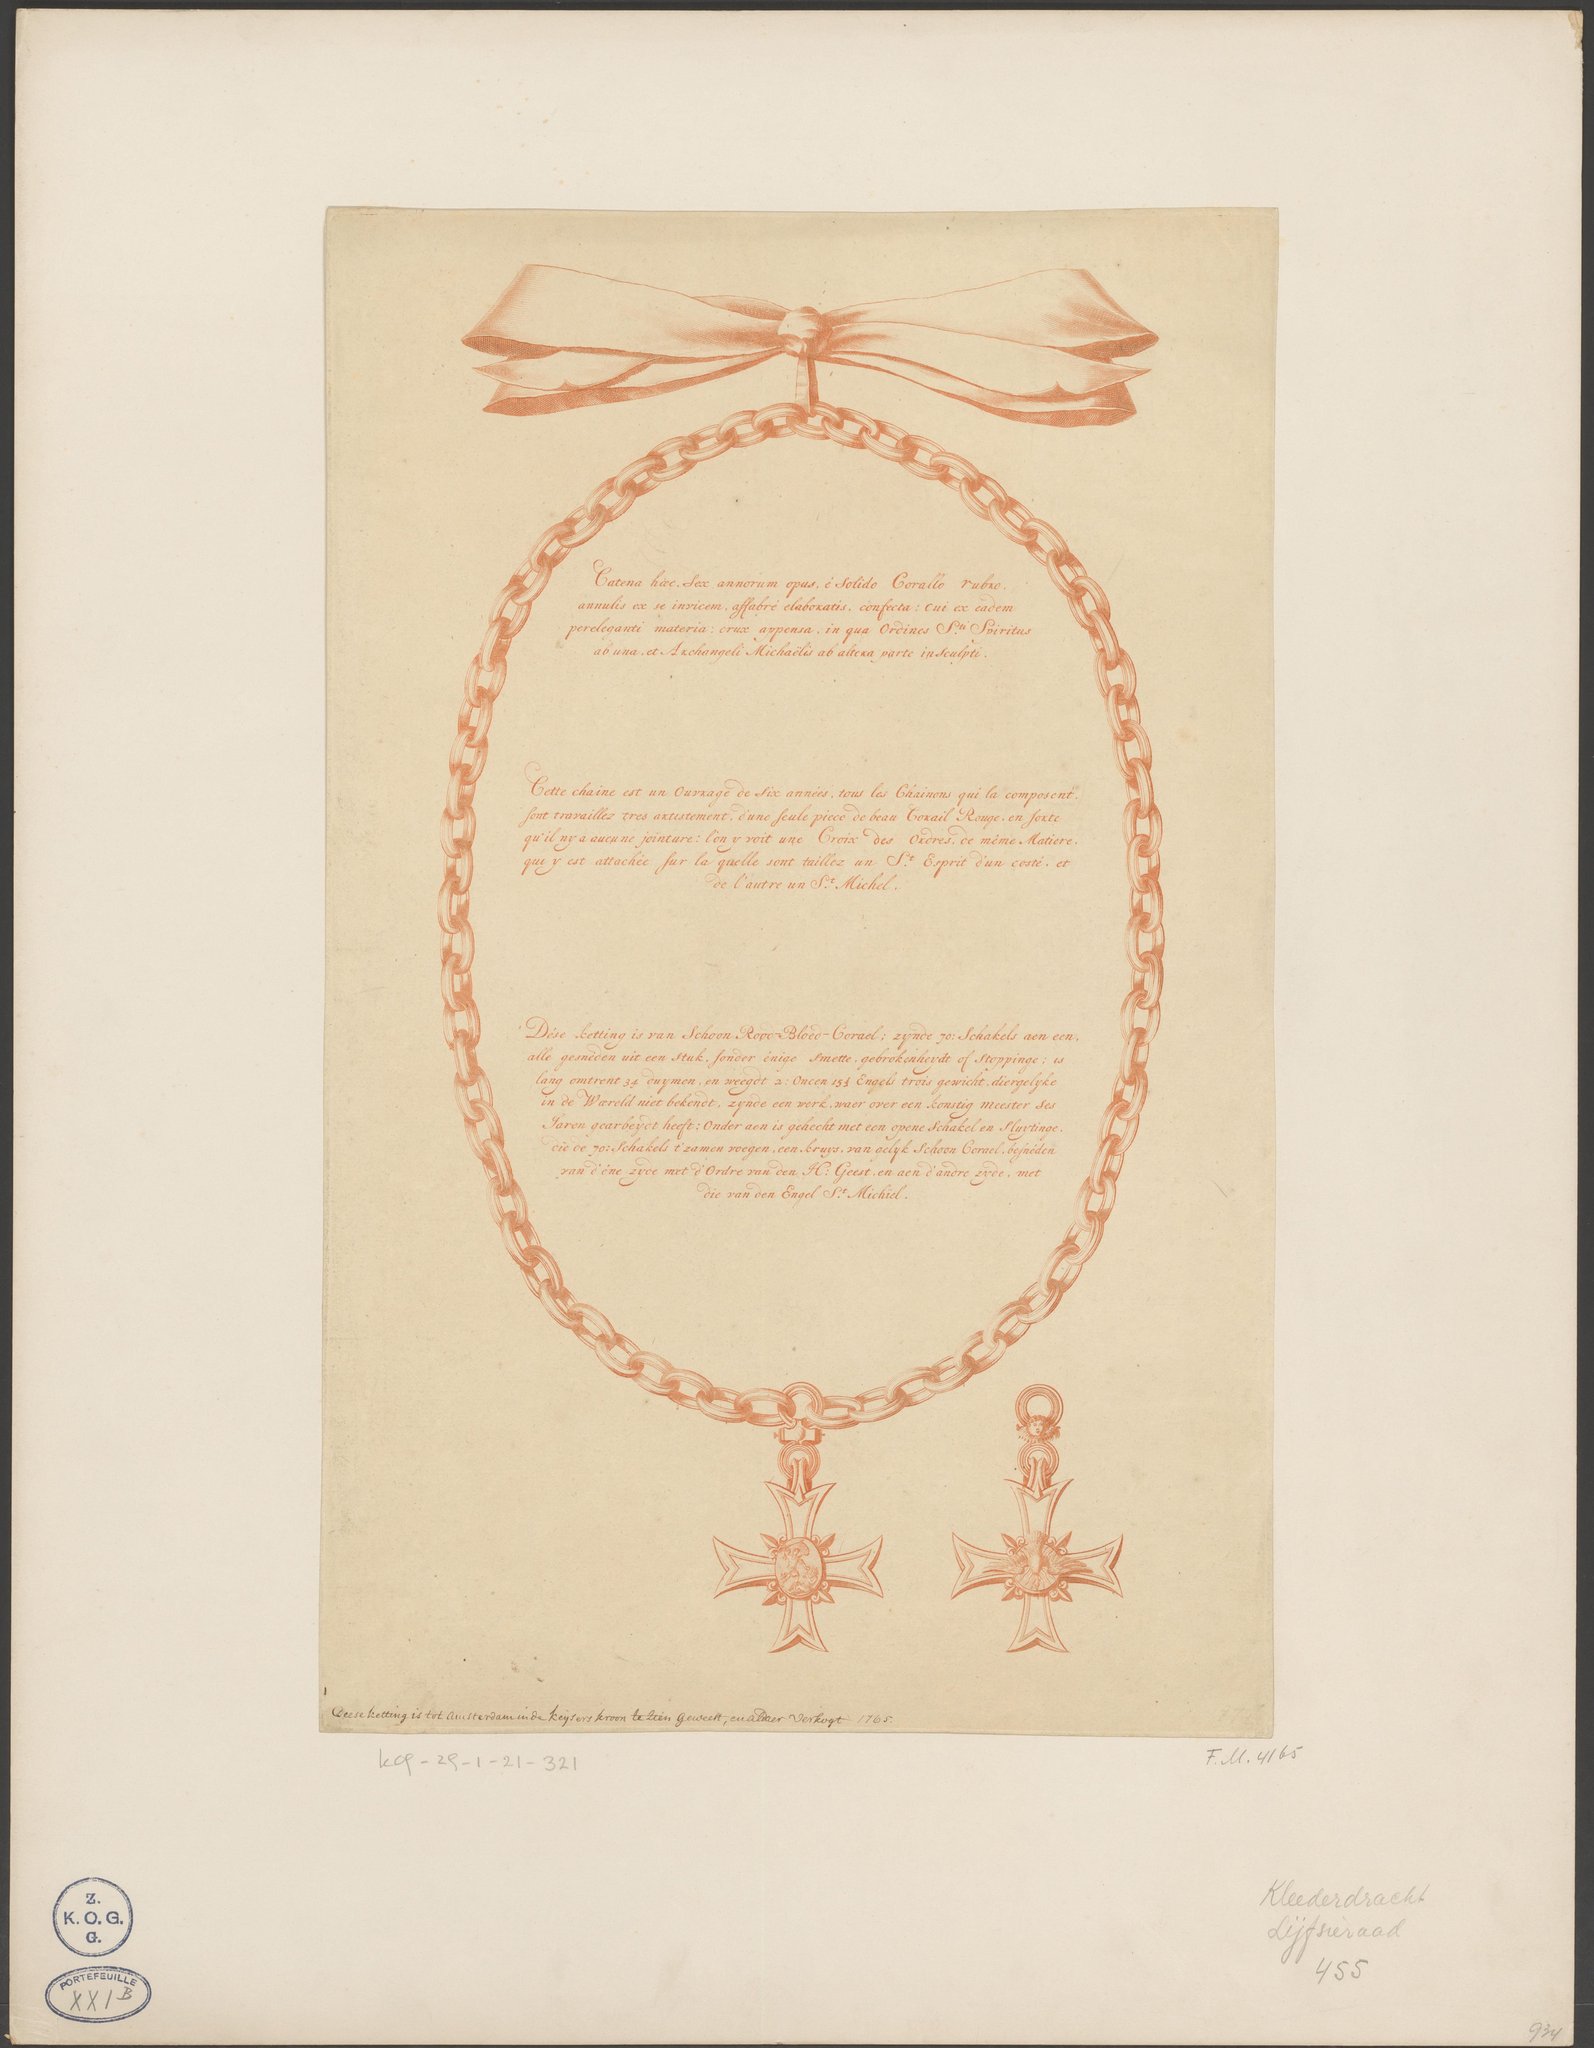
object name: print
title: Bloedkoralen ketting met een kruis van de Orde van de Heilige Geest een kruis van de Orde van Sint-Michiel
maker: Anonymous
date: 1764-1766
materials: paper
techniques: engraving, etching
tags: knighthood order, knighthood order of the holy spirit, necklace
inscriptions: stamp, collector's mark: Lugt 1641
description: Een ketting met schakels van bloedkoraal met een kruis van de Orde van de Heilige Geest en een kruis van de Orde van Sint-Michiel.Bovenaan een strik. In het midden van de ketting staat een beschrijving van de ketting. De ketting is in 1765 te zien geweest in De keizerskroon en daar verkocht. Onderwerpsrubrieken binnen de Atlas Zeden en Gewoonten: Zeden en Gewoonten in Engeren Zin, De Kleeding, Lijfsieraden, waaiers, schoeisel.